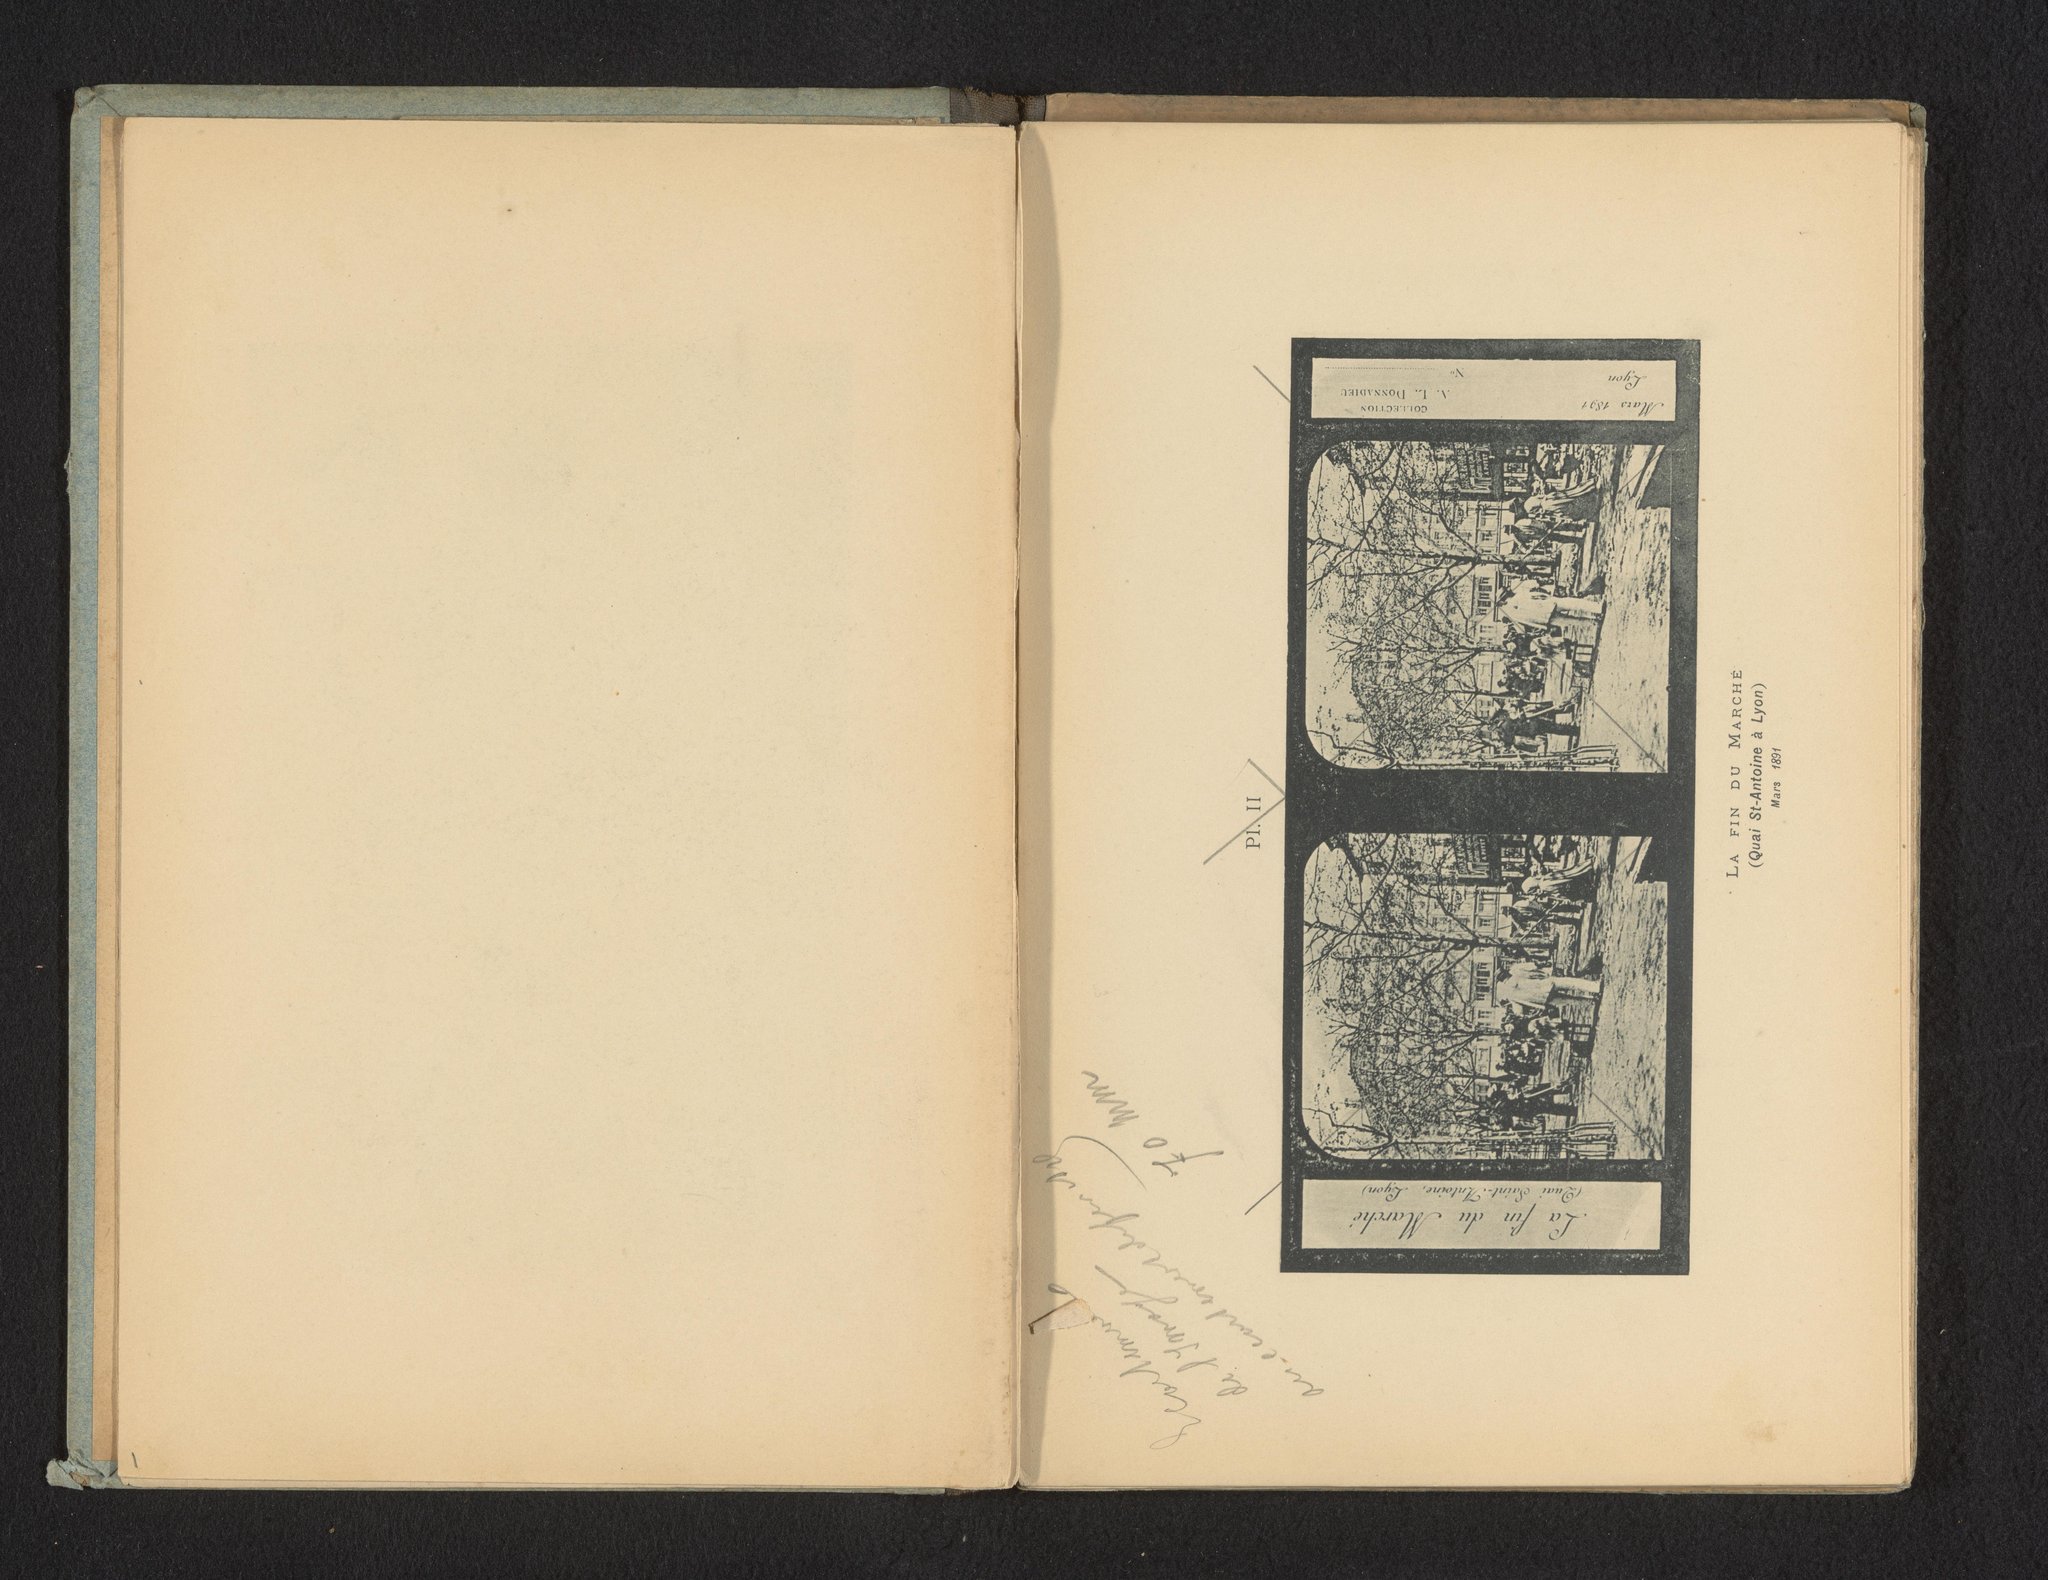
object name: stereograph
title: Stereofoto van een gezicht op de markt van Quai Saint-Antoine te Lyon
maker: adolphe louis donnadieu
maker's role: wetenschapper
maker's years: 1840-1911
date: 1882-1892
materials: paper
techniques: photograph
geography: lyon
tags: market, street (+ city(-scape) with figures, staffage), lyon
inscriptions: inscription: ‘Pl. II’, inscription: ‘Mars 1891’, annotation: ‘[...] 70 mm’